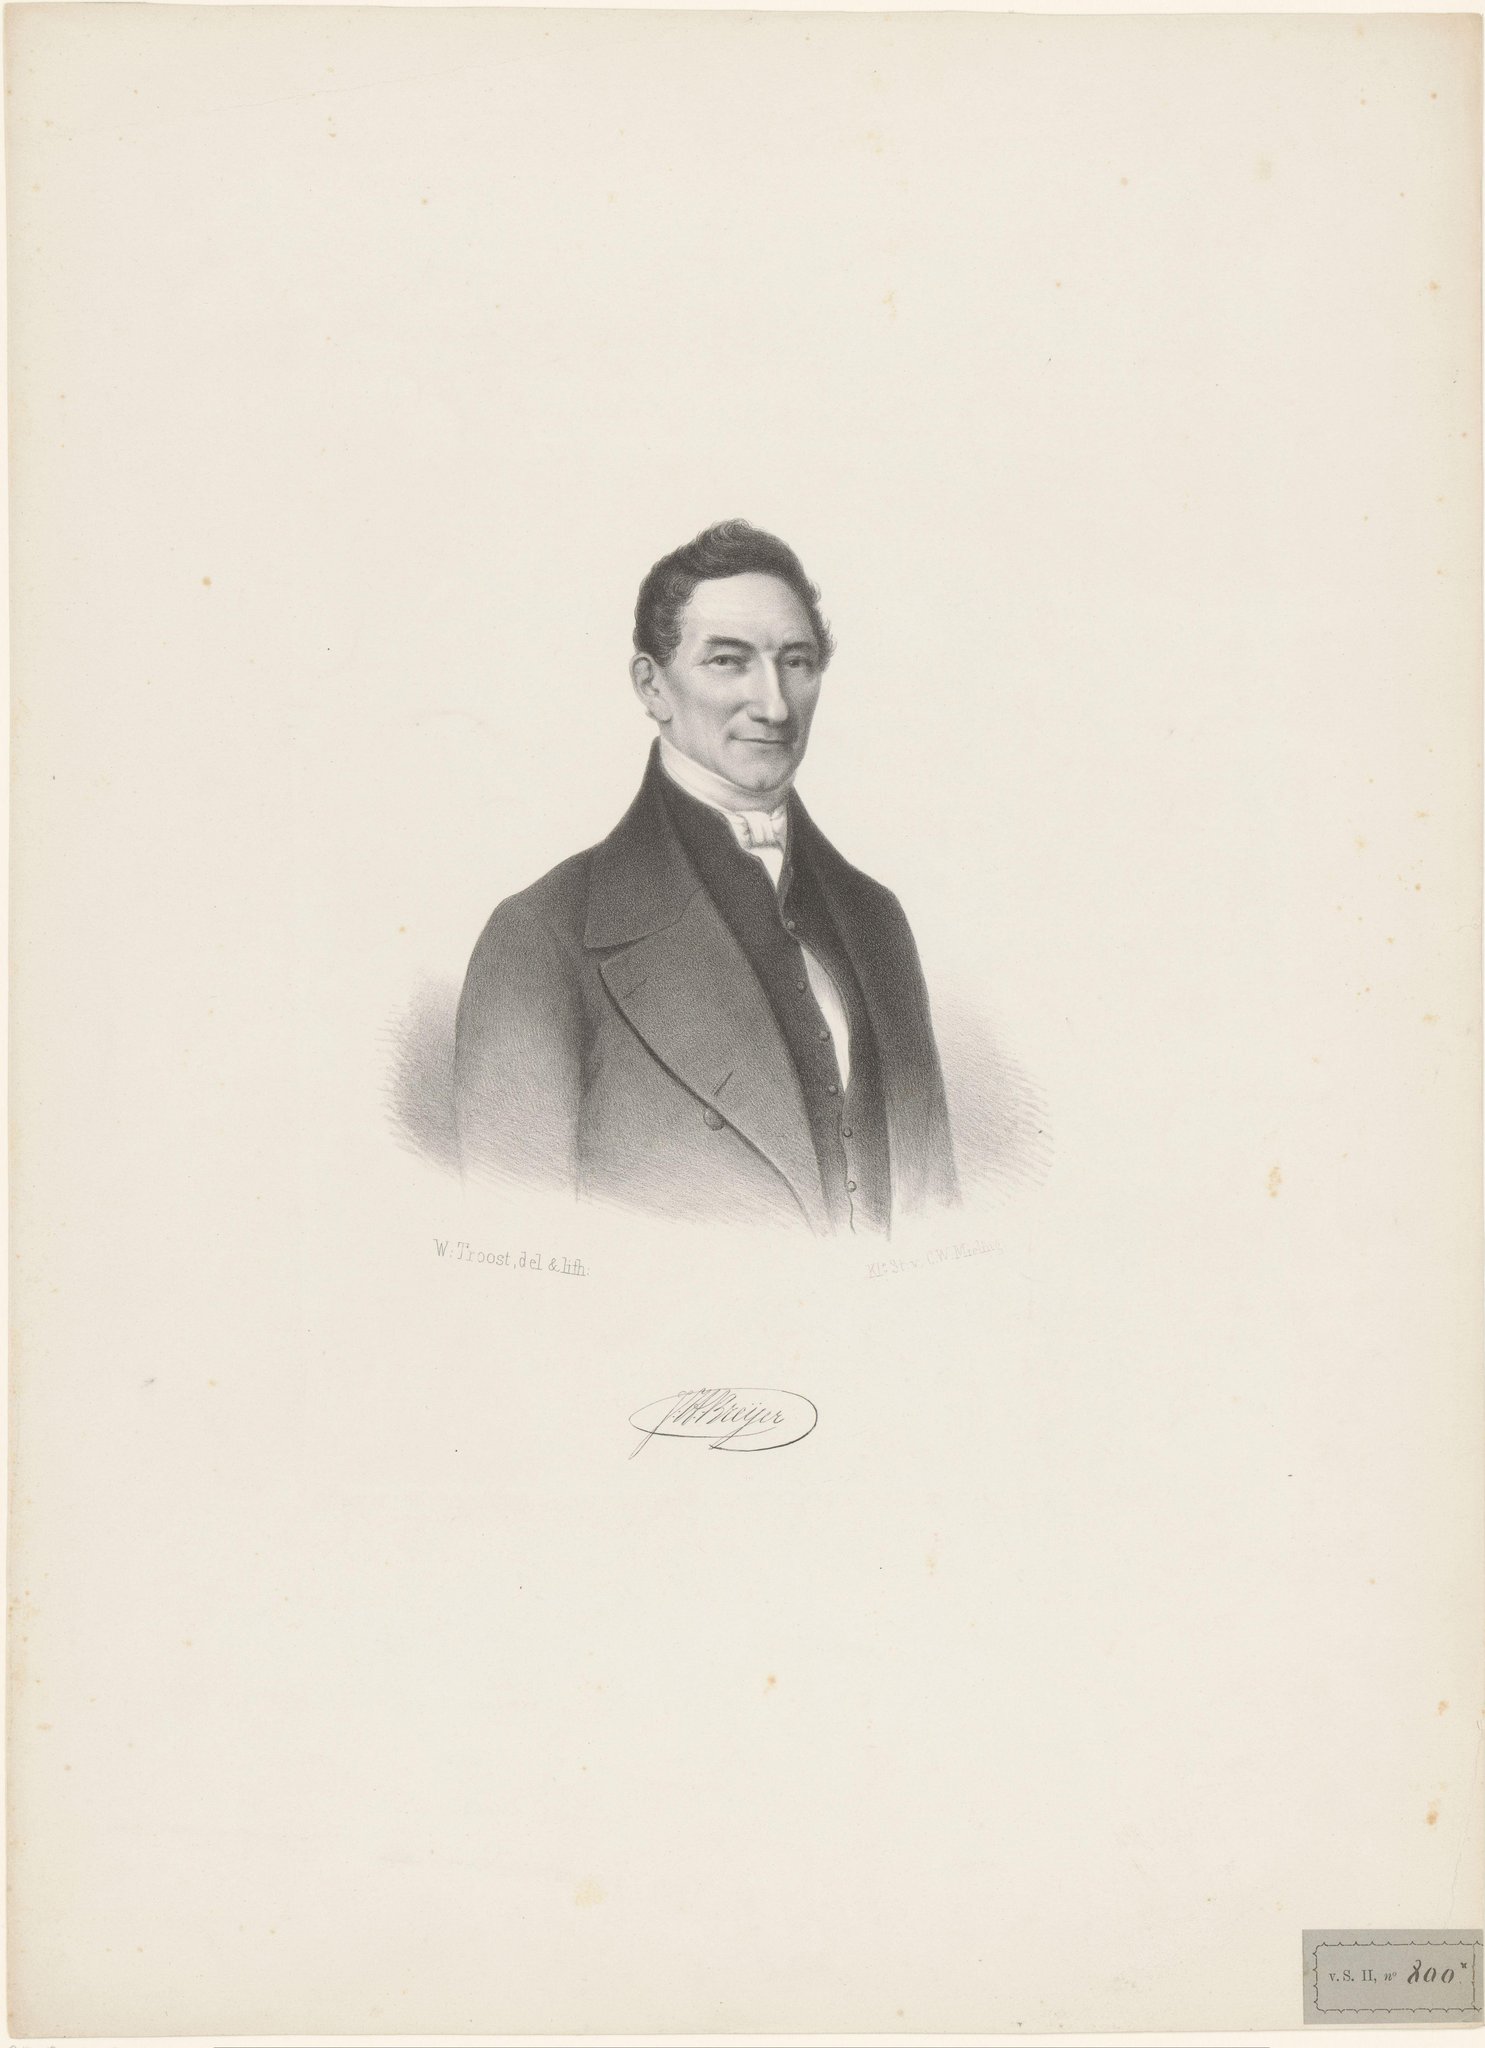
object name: print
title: Portret van Jan Hendrik Breijer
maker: willem troost (ii)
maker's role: draughtsman, painter, print maker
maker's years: 1812-1893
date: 1847-1865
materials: paper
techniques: lithograph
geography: the hague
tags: historical persons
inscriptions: collector's mark: Lugt 2228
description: Onder het portret de signatuur van de geportretteerde.